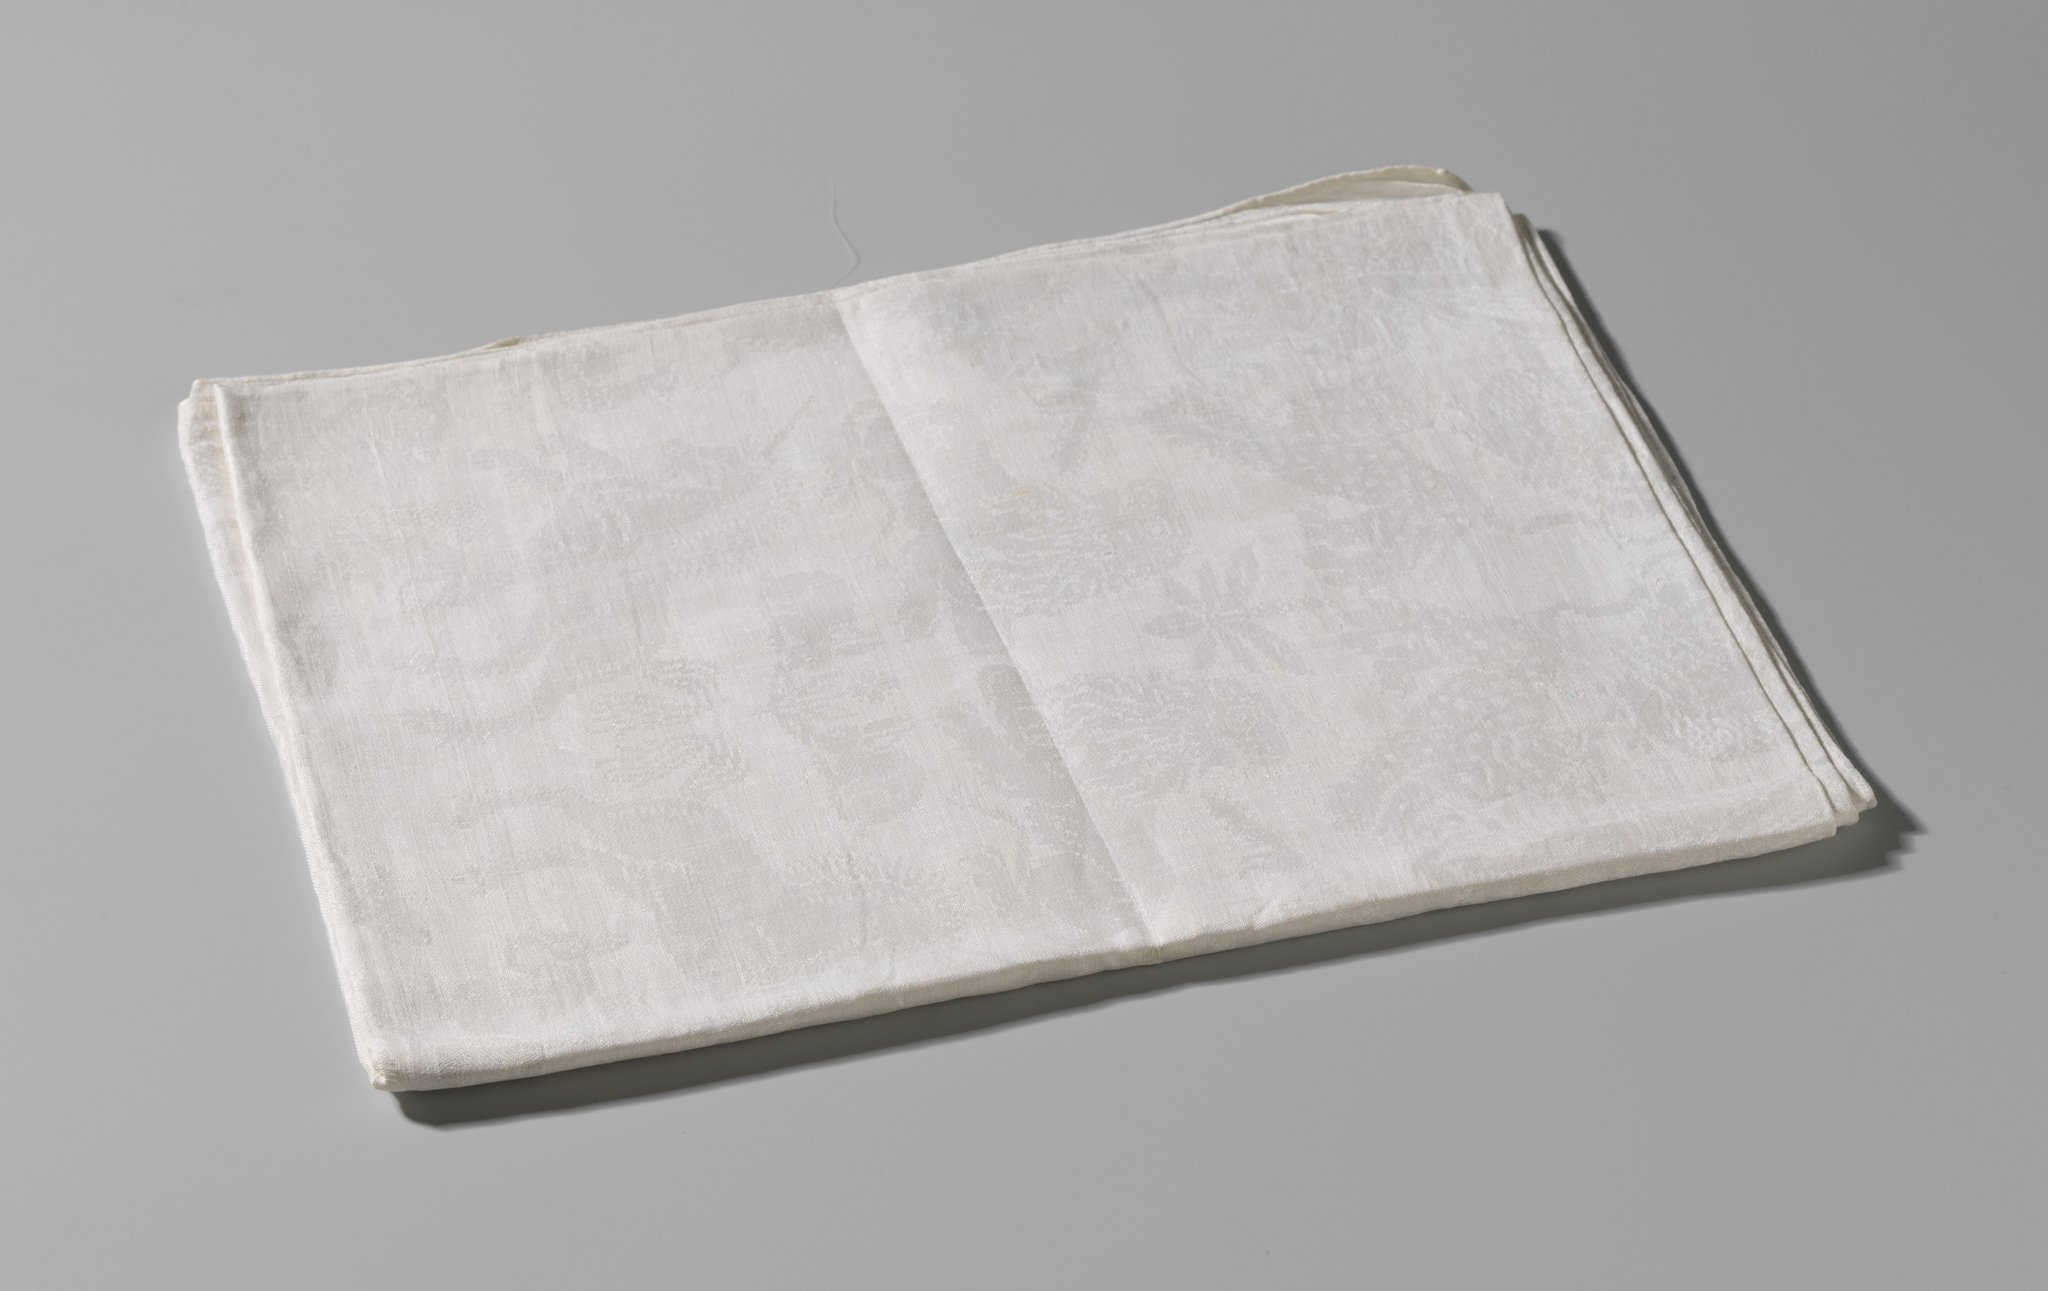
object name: fragment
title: Tafellaken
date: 1640-1660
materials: linen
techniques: damask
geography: flanders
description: Fragment van wit linnen damasten tafellaken met Orpheus musicerende voor de dieren.